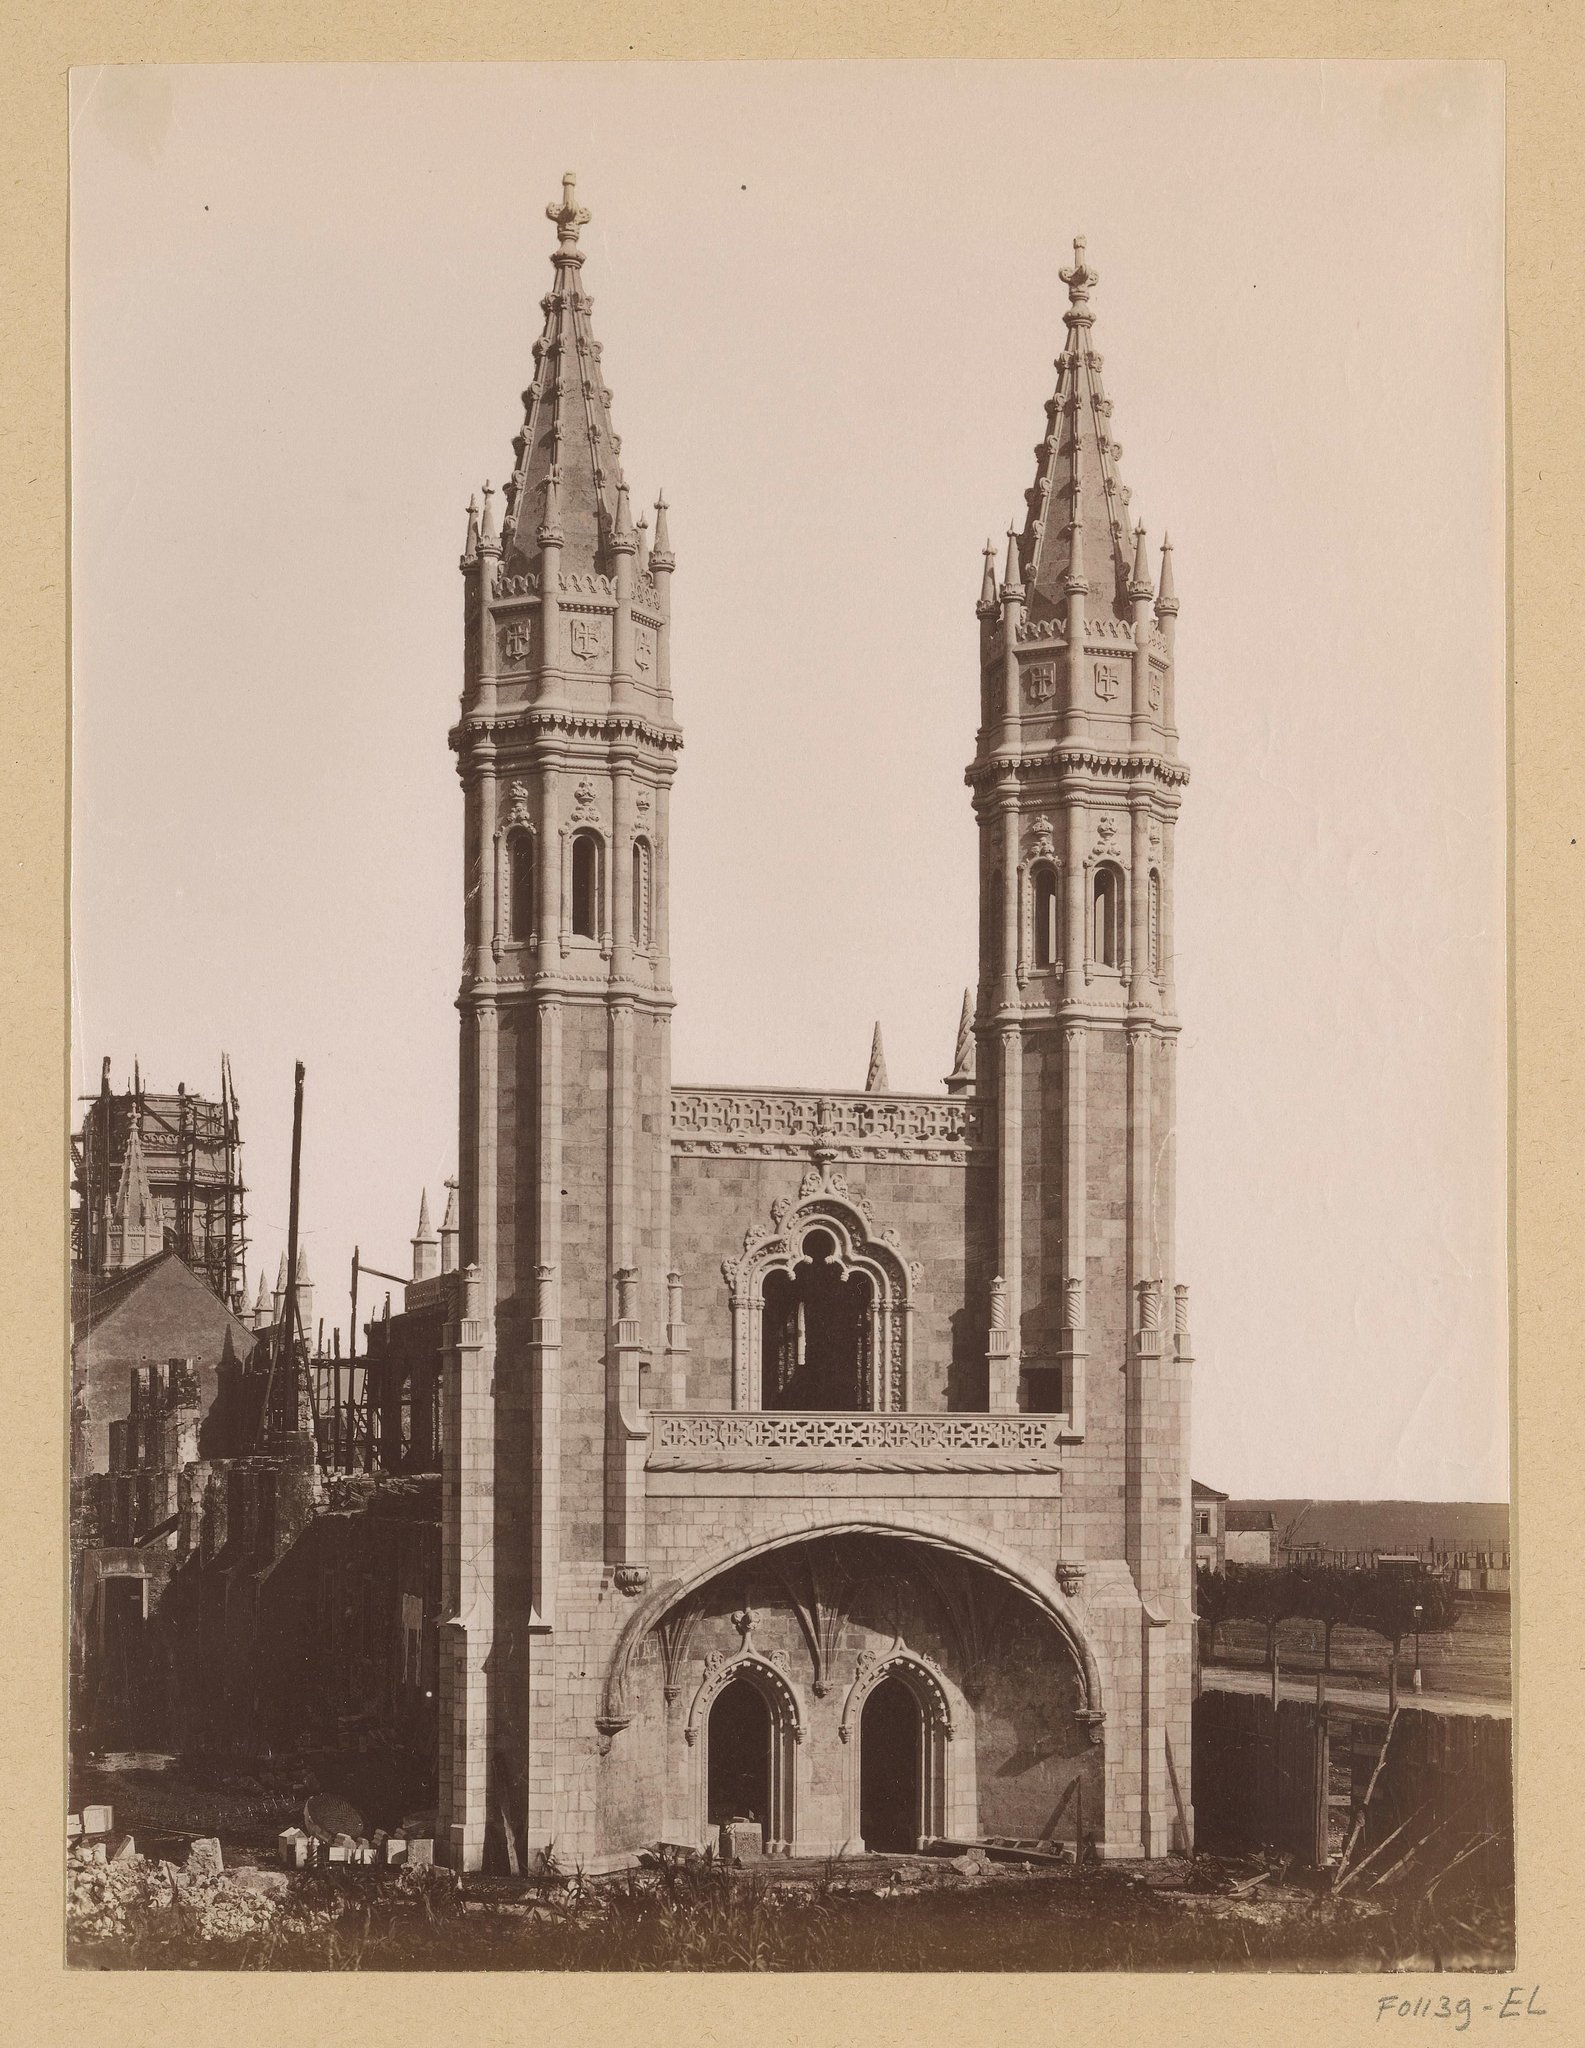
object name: album leaf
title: Gezicht op de westelijke vleugel van het Mosteiro dos Jerónimos in Lissabon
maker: francisco rocchini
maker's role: fotograaf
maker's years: 1822-1895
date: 1863-1890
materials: paper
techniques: albumen print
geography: lisbon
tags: building-site